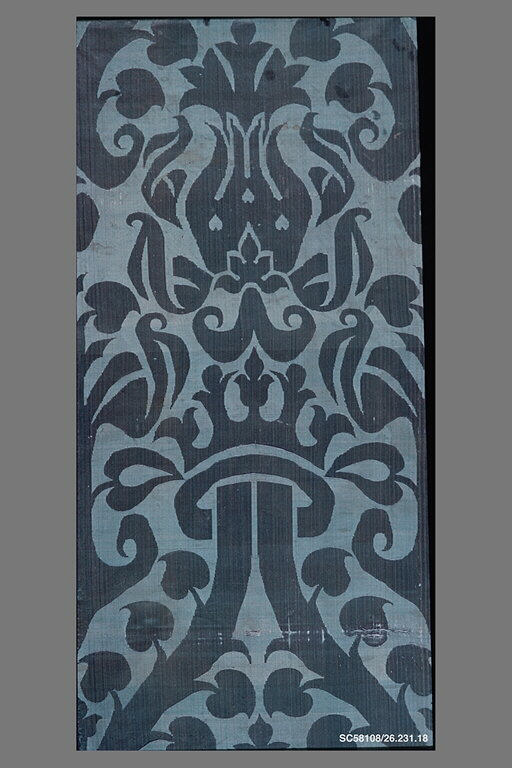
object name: piece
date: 1501-1550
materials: silk